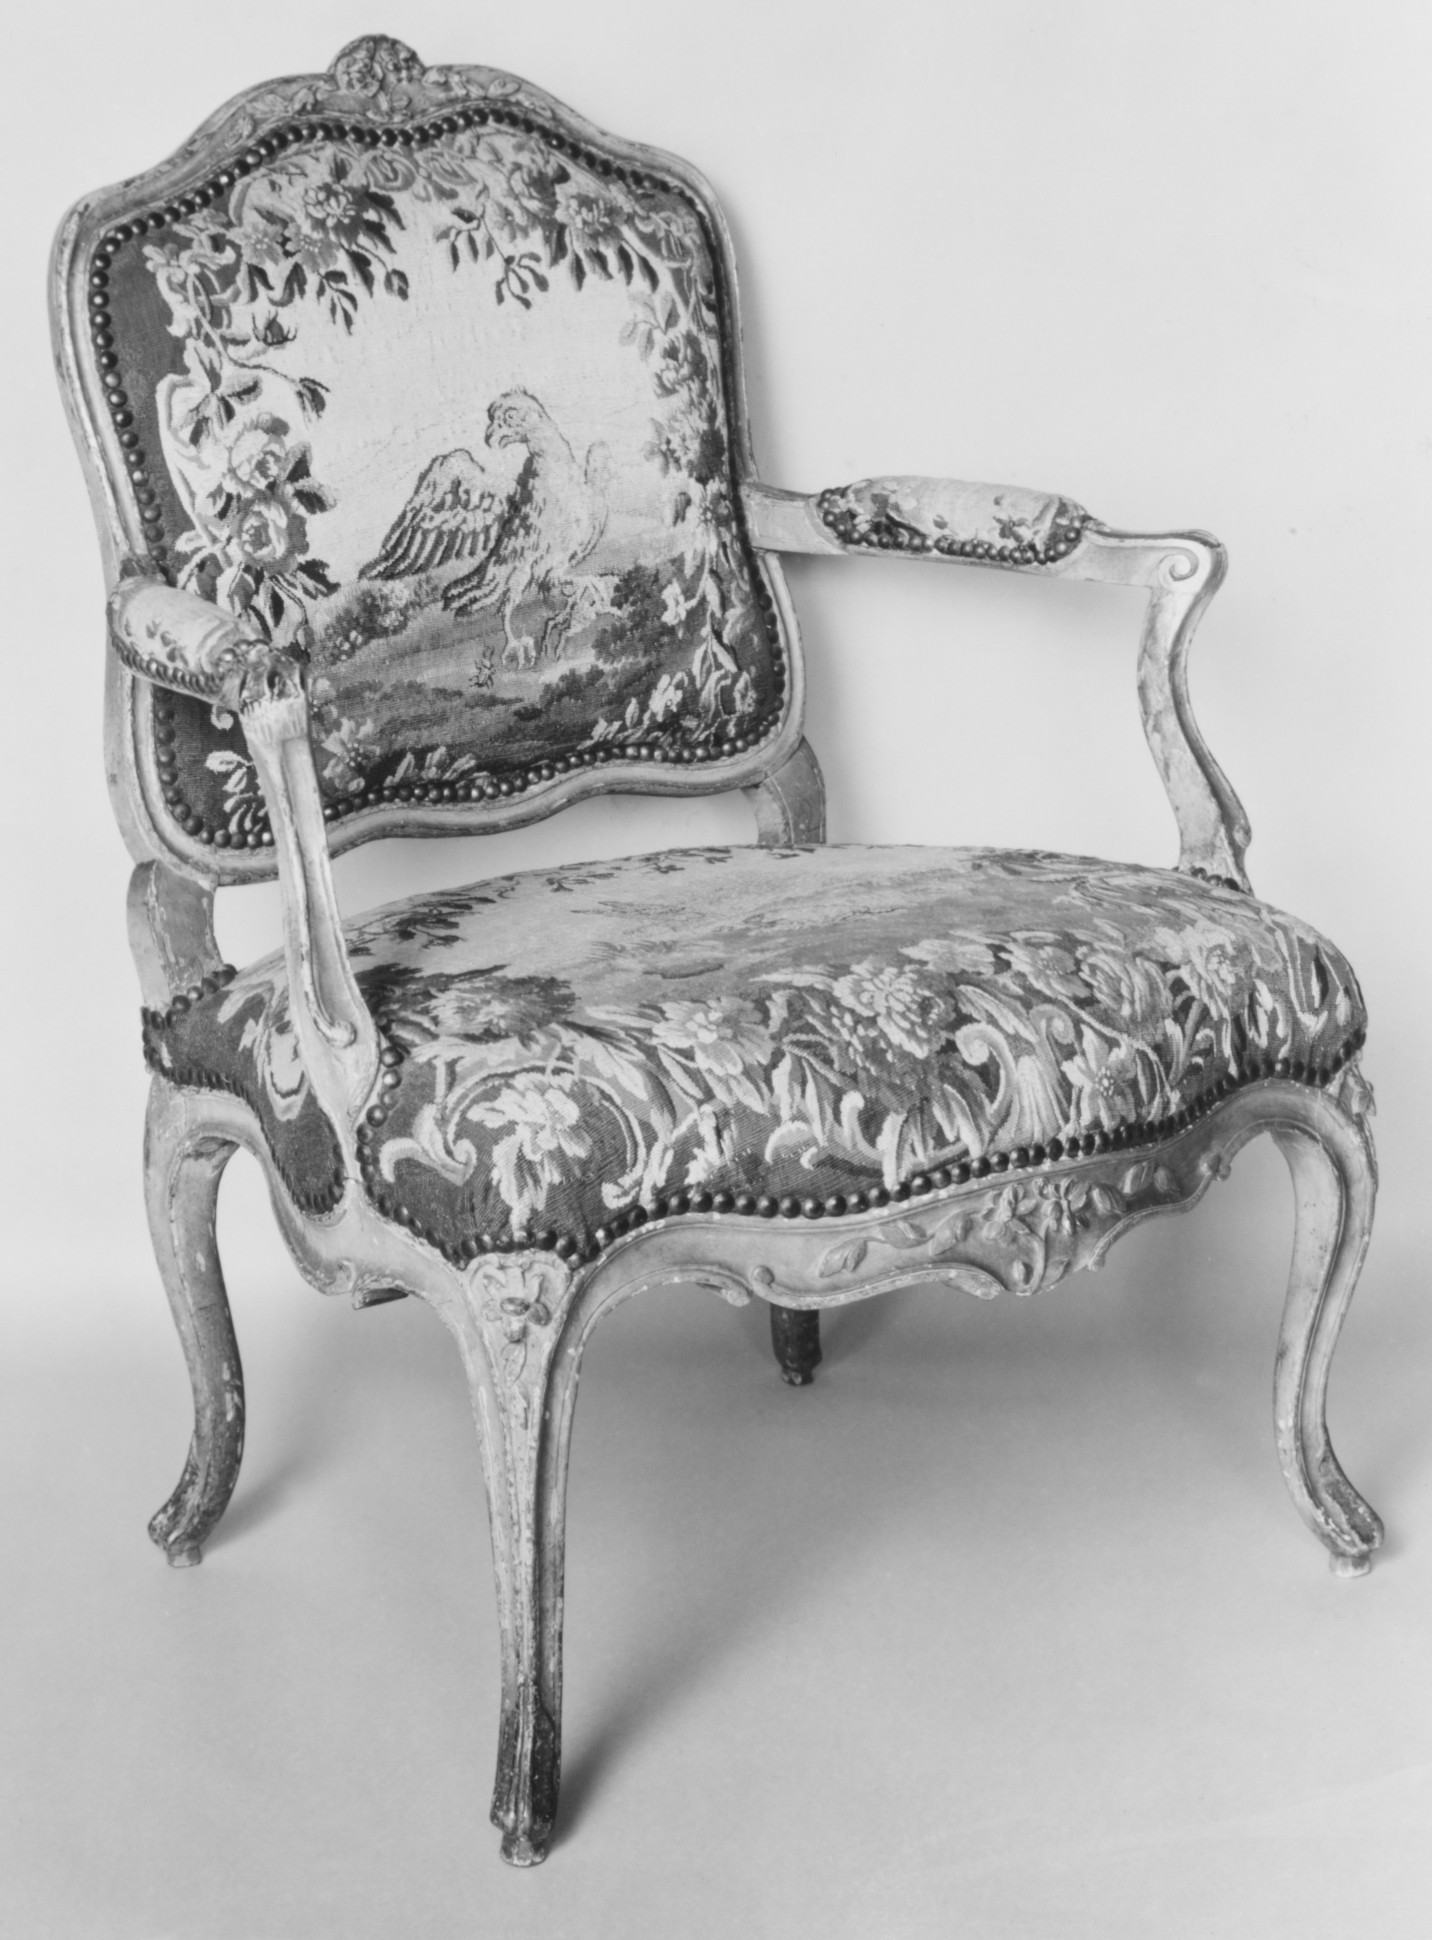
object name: armchair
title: Armchair (part of a set of nine)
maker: aubusson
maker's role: factory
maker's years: 1665-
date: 1734-1766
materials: wood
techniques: carving, painting, tapestry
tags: birds,flowers